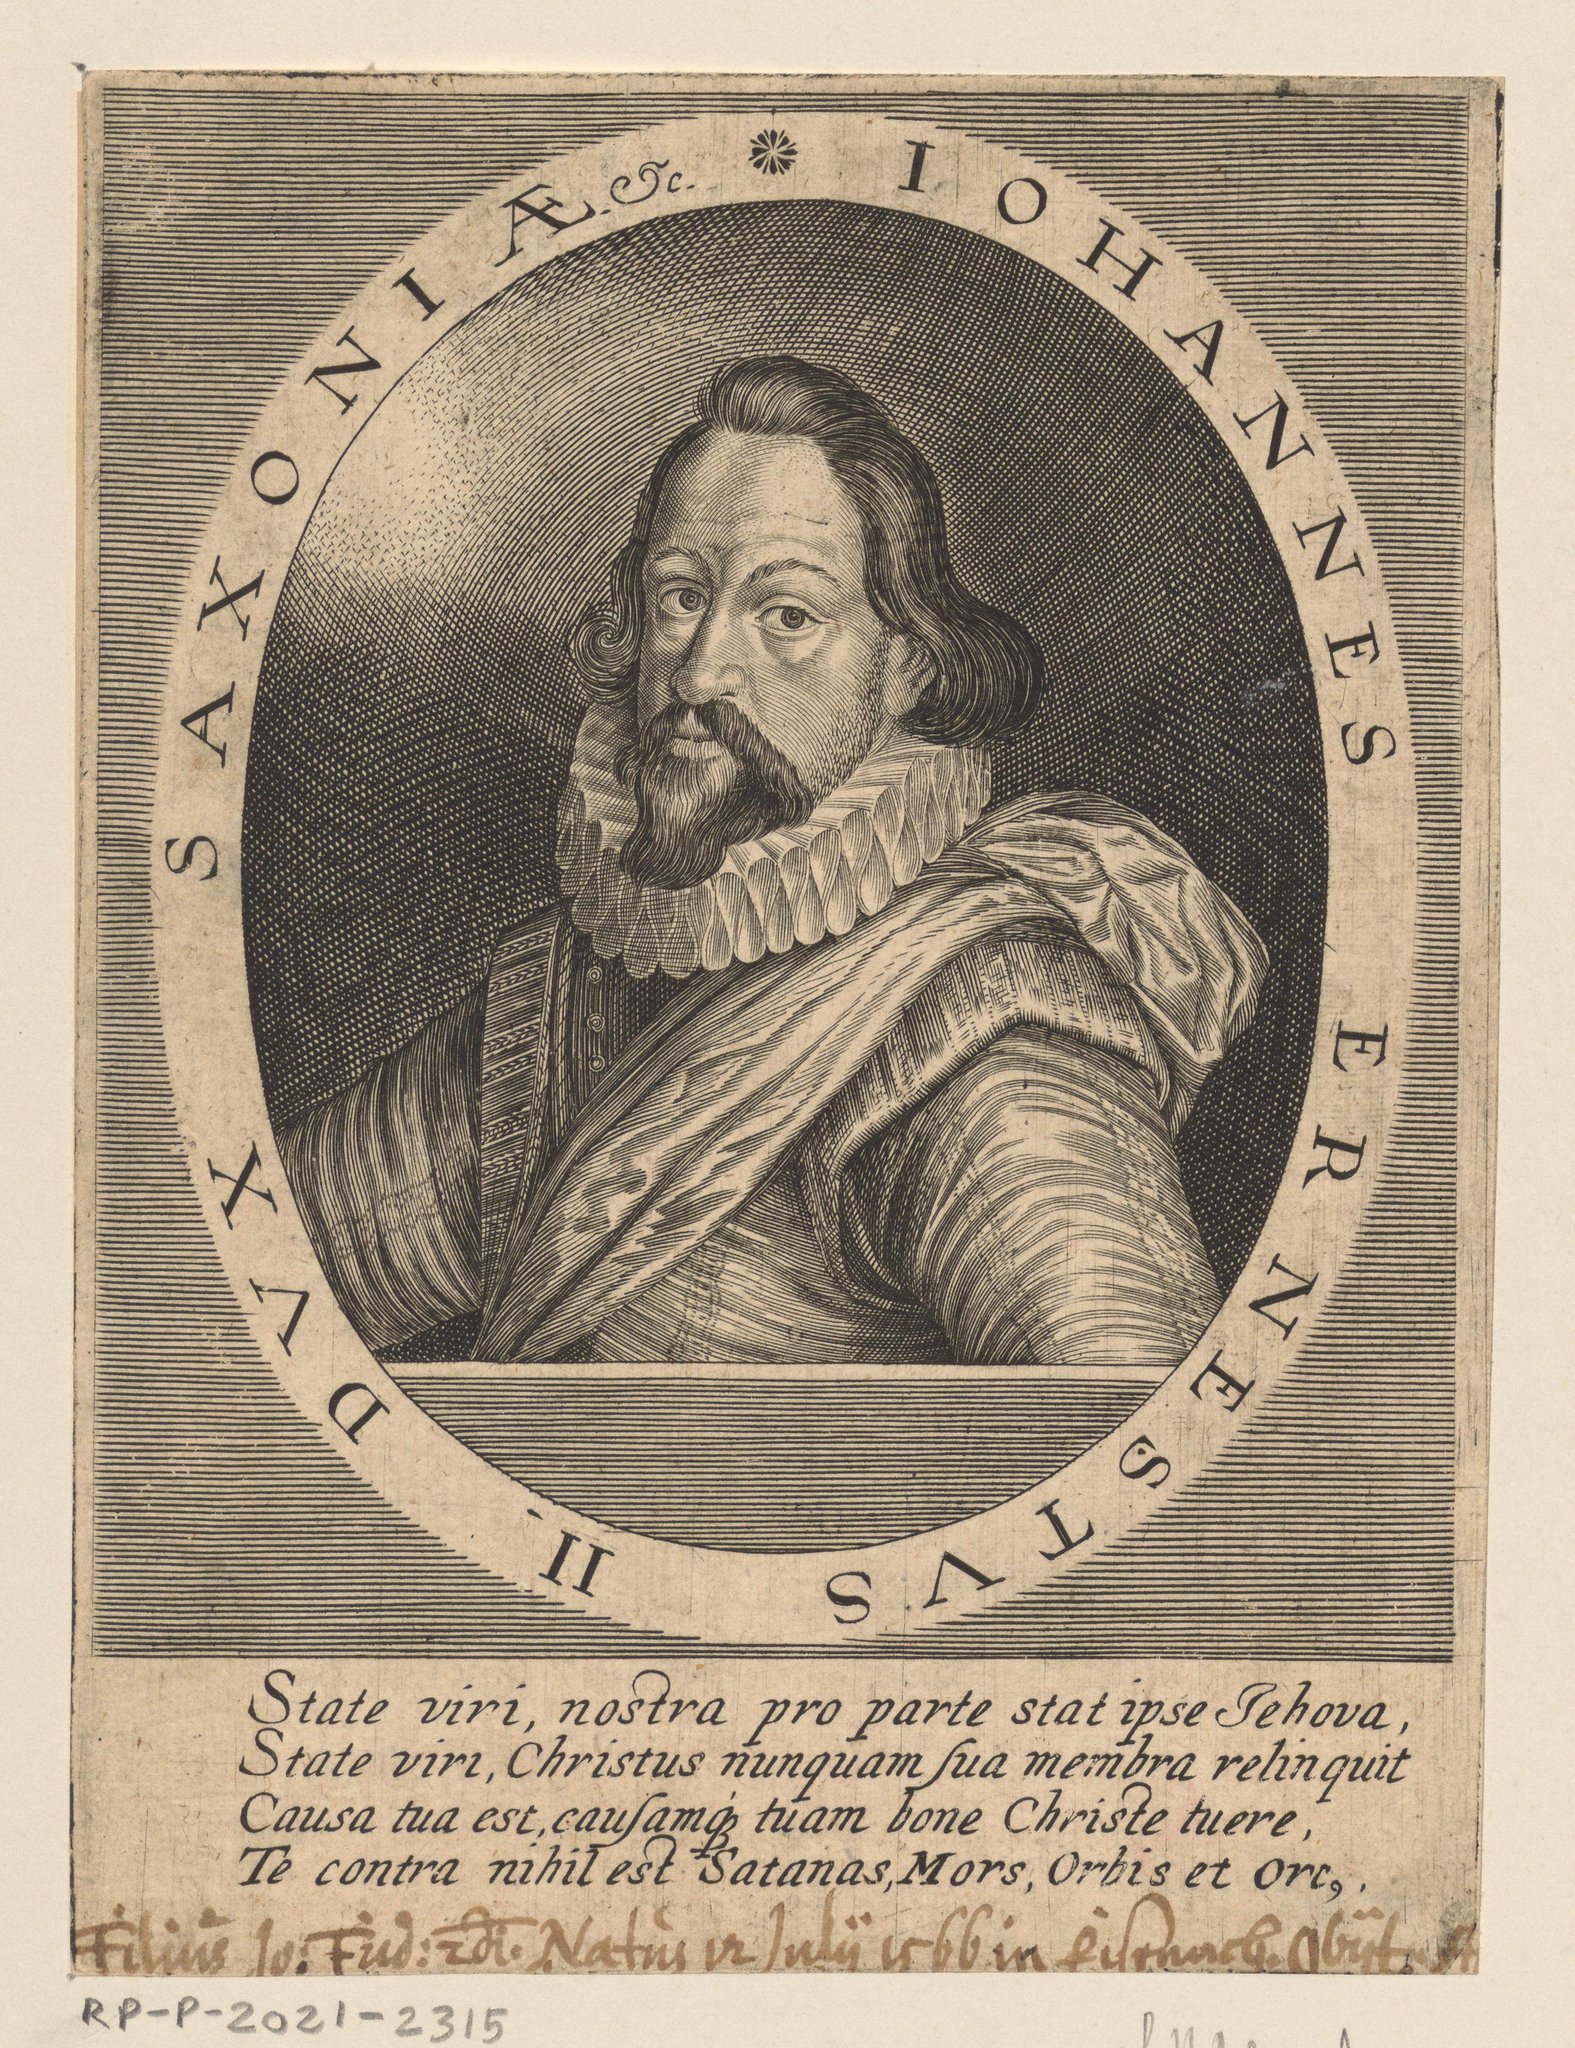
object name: print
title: Portret van Johann Ernst II, hertog van Saksen-Weimar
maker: Anonymous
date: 1600-1699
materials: paper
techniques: engraving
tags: historical persons, ruler, sovereign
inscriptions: inscription: ‘"Filius lo Fud: (...)"’